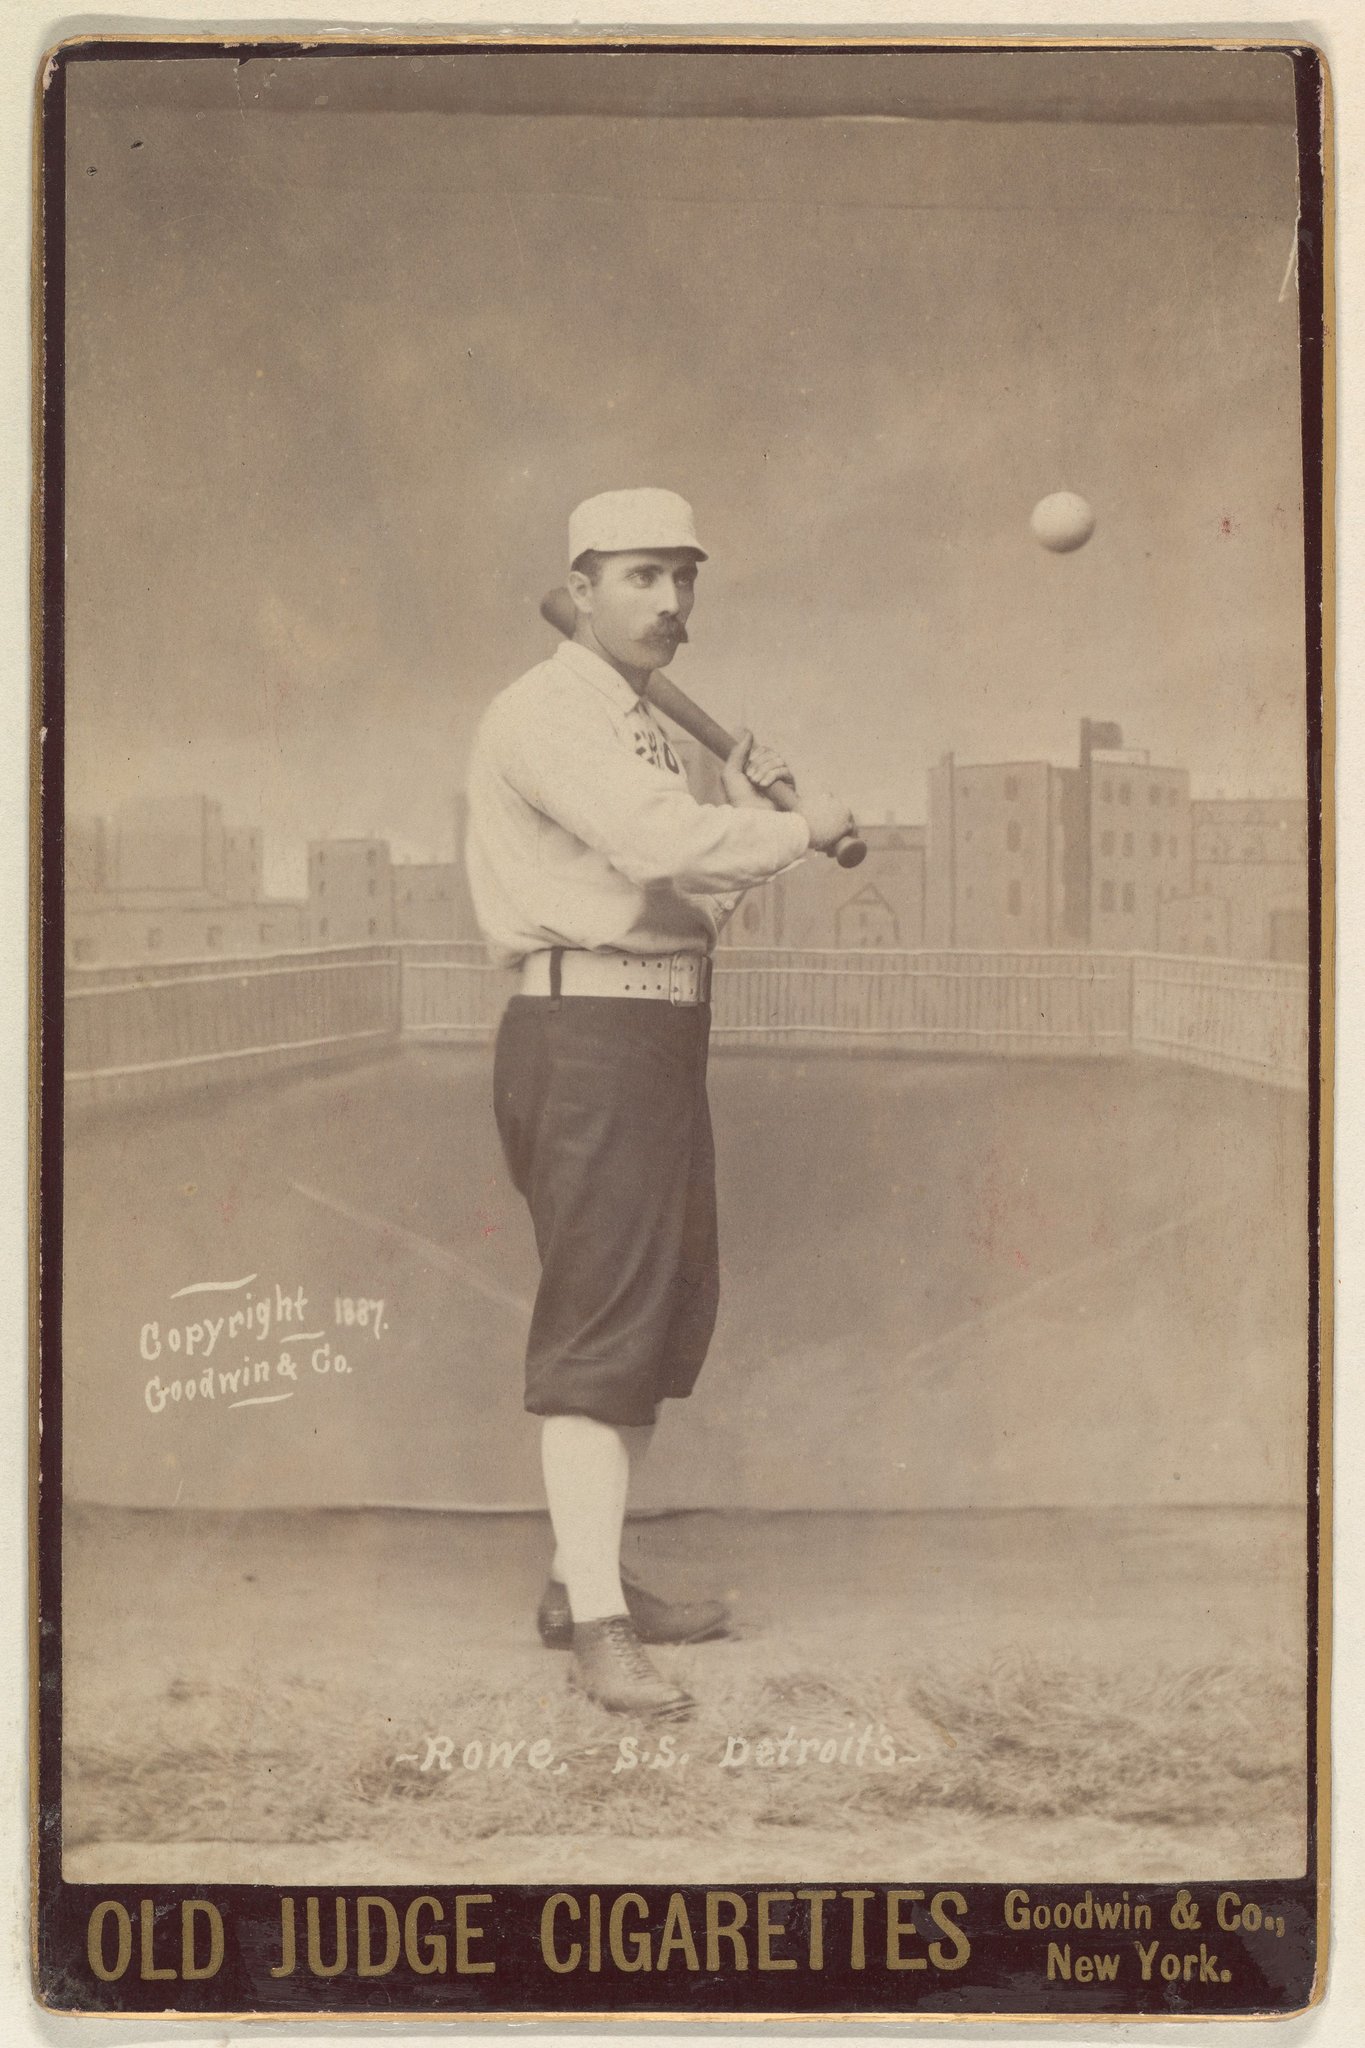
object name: baseball card, photograph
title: Rowe, Shortstop, Detroit, from the series Old Judge Cigarettes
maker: goodwin & company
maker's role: publisher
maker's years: 1850-1950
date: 1887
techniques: albumen print, photography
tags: men,portraits,baseball,athletes